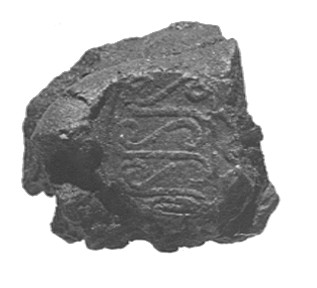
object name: sealing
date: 2030-1640 BCE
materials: clay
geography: egypt